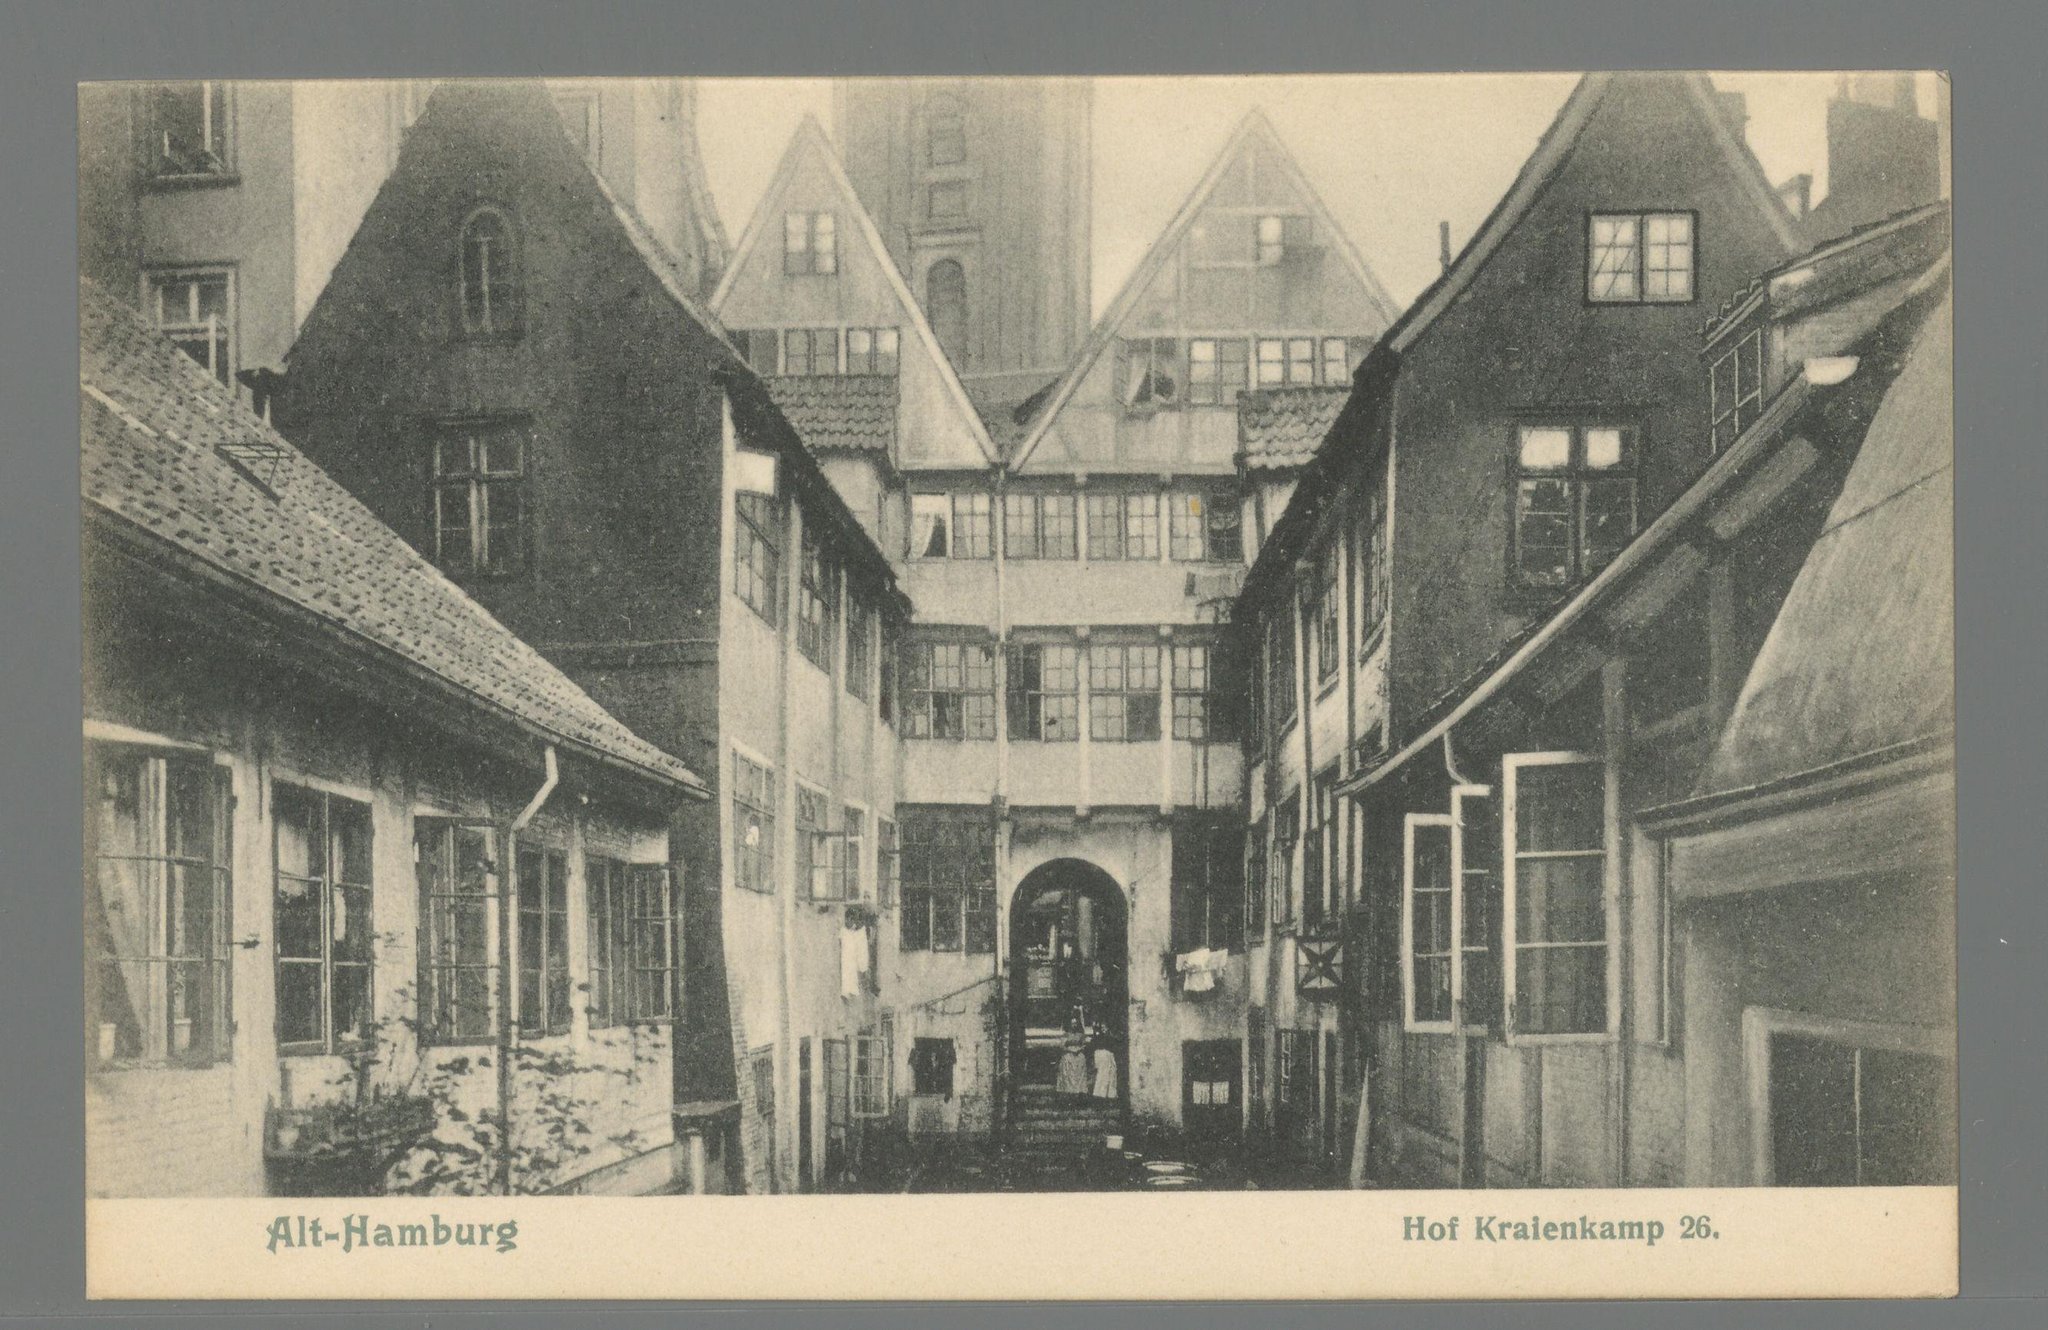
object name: photomechanical print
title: Alt-Hamburg. Hof Kraienkamp 26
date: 1905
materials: cardboard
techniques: photograph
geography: hamburg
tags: street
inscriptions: date